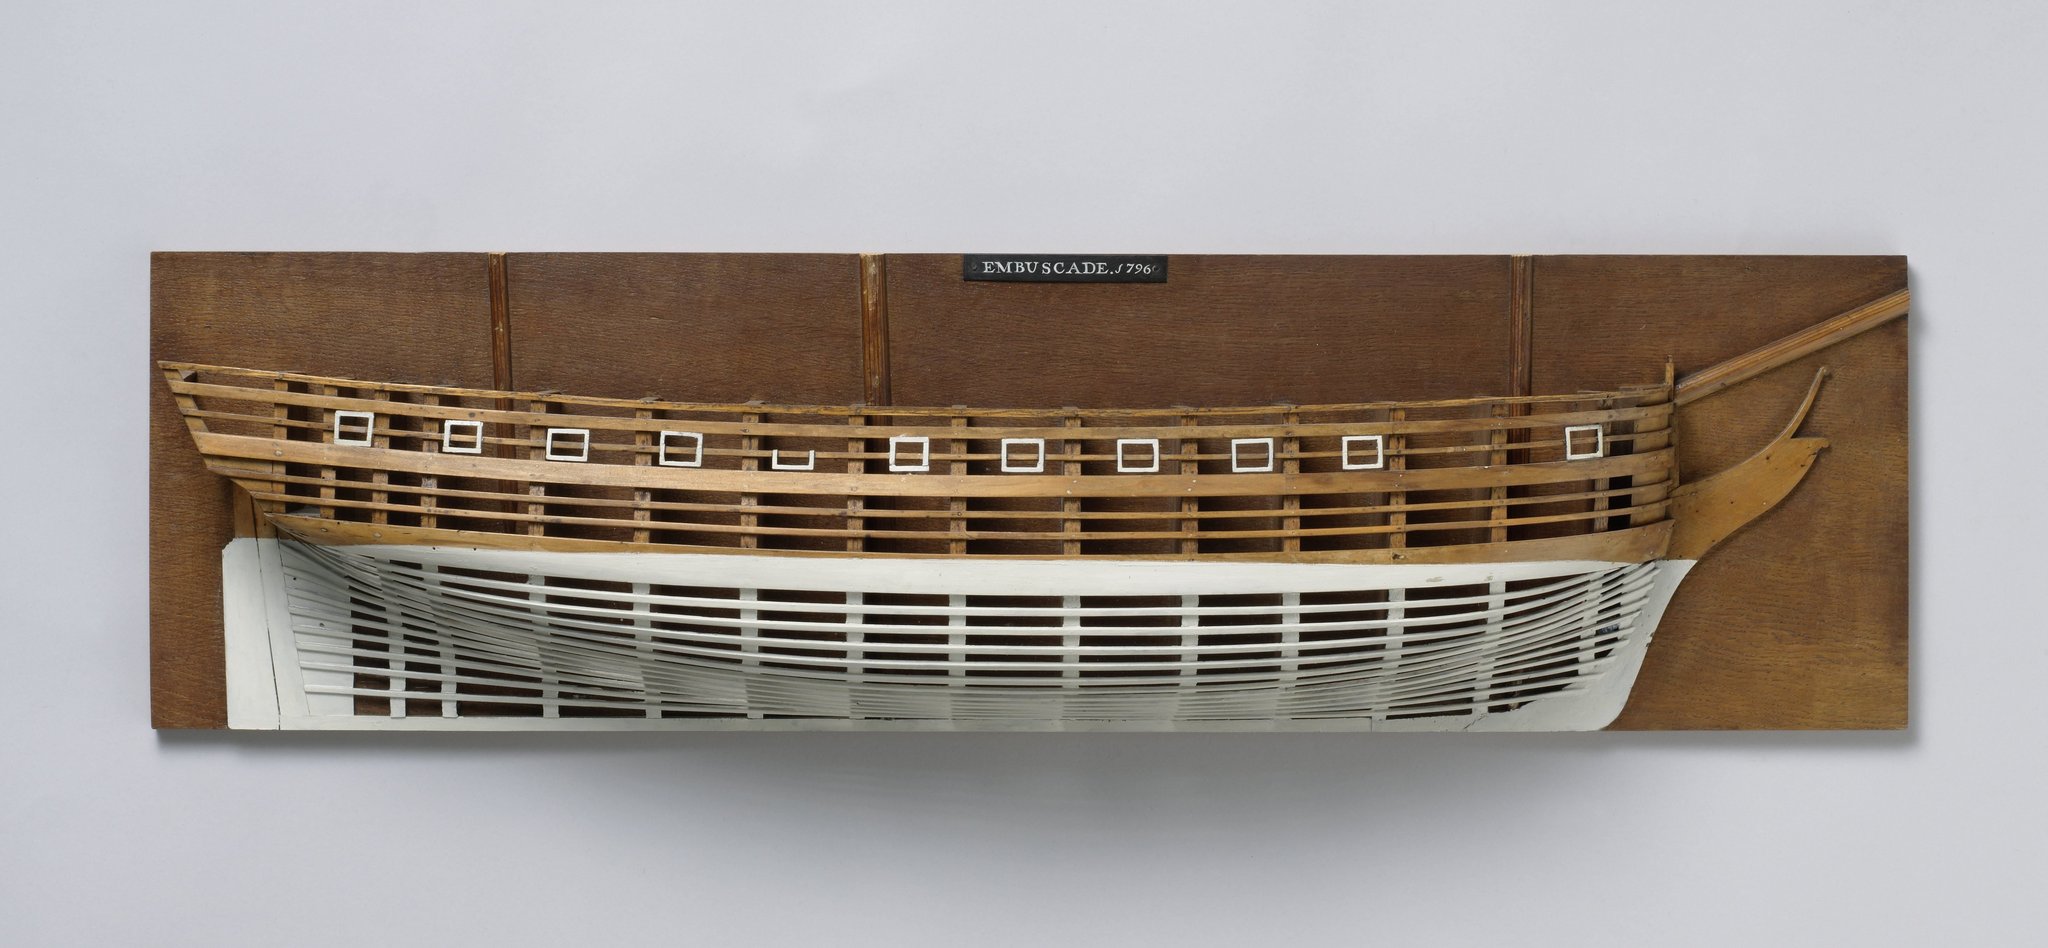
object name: half model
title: Half Model of a 32-Gun Frigate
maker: Anonymous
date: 1796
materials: wood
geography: netherlands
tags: embuscade (schip)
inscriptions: inscription, top centre, on a rectangular black label: ‘EMBUSCADE. 1796’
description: Mallenmodel (stuurboord) van een driemaster. Twaalf geschutpoorten op één dek. Gewrongen spiegel, hol wulf, geen details van hek of zijgalerij; recht roer met vierkante roerkoning en kiel met hiel. De zeeg loopt iets op aan beide uiteinden, één barkhout en één reehout. Gepiekt rondspant. Schaal ca. 1:55 (afgeleid).